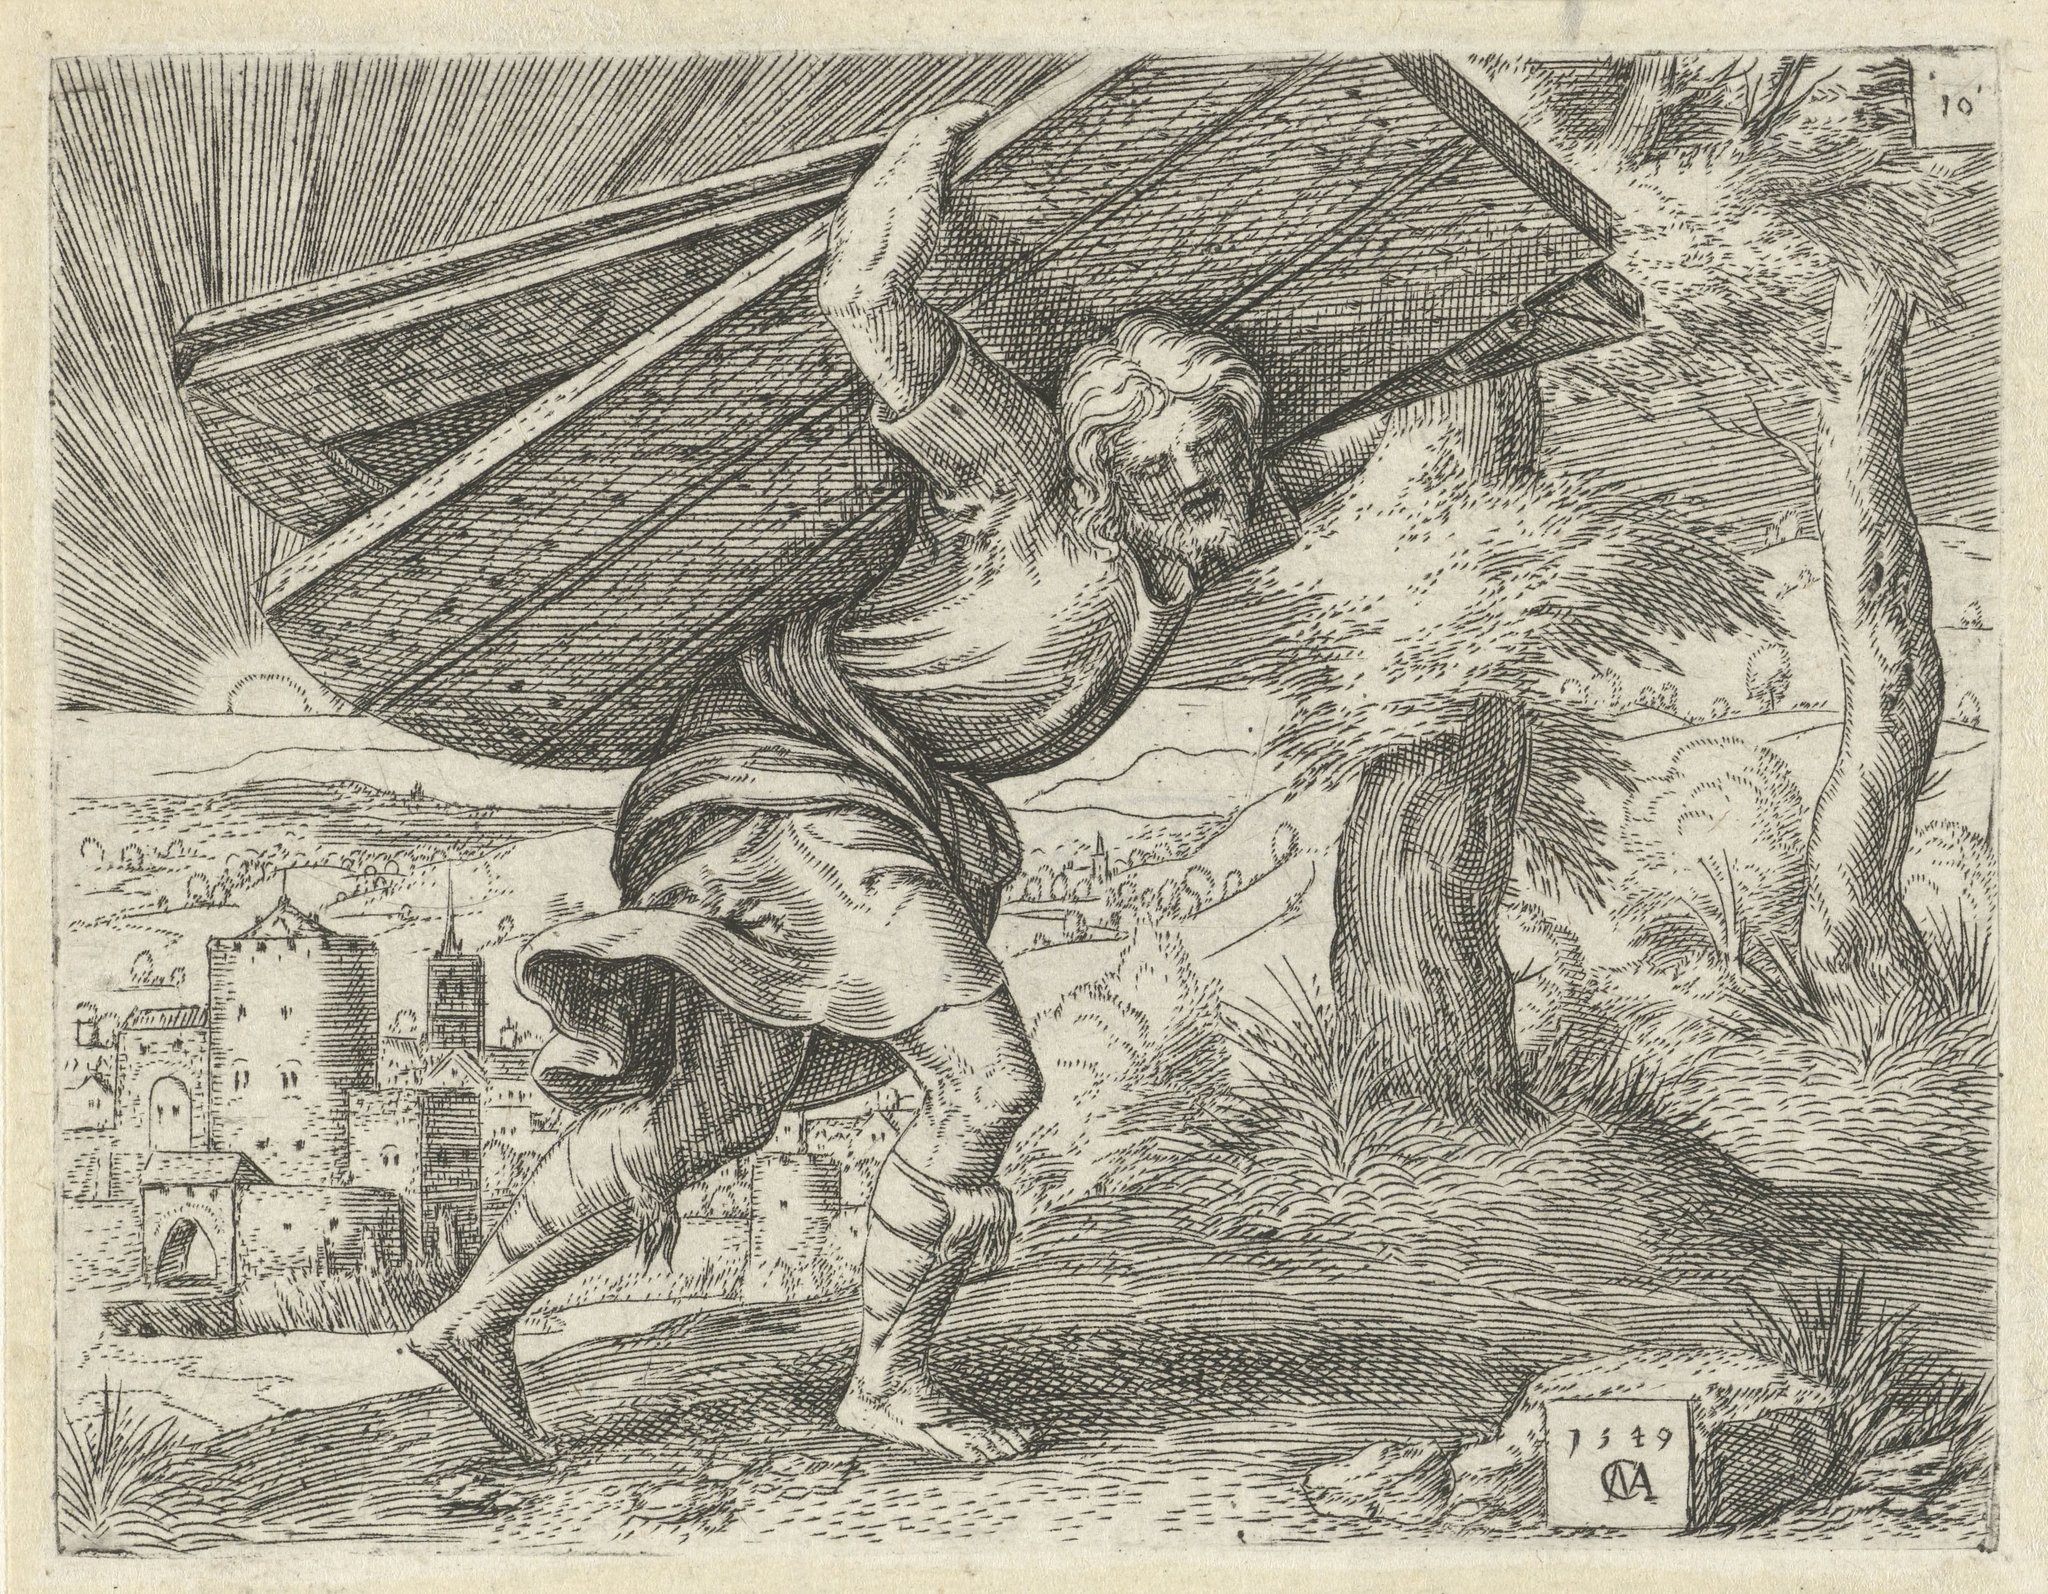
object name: print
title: Simson draagt de poorten van Gaza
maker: cornelis massijs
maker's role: painter, print maker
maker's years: 1510-1557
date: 1549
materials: paper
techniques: engraving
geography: antwerp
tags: samson takes the doors of the city-gate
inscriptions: collector's mark: Lugt 2542, collector's mark: Lugt 2228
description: Simson draagt de poorten van de stad Gaza op zijn schouders. Op de achtergrond Gaza met de open stadspoort.